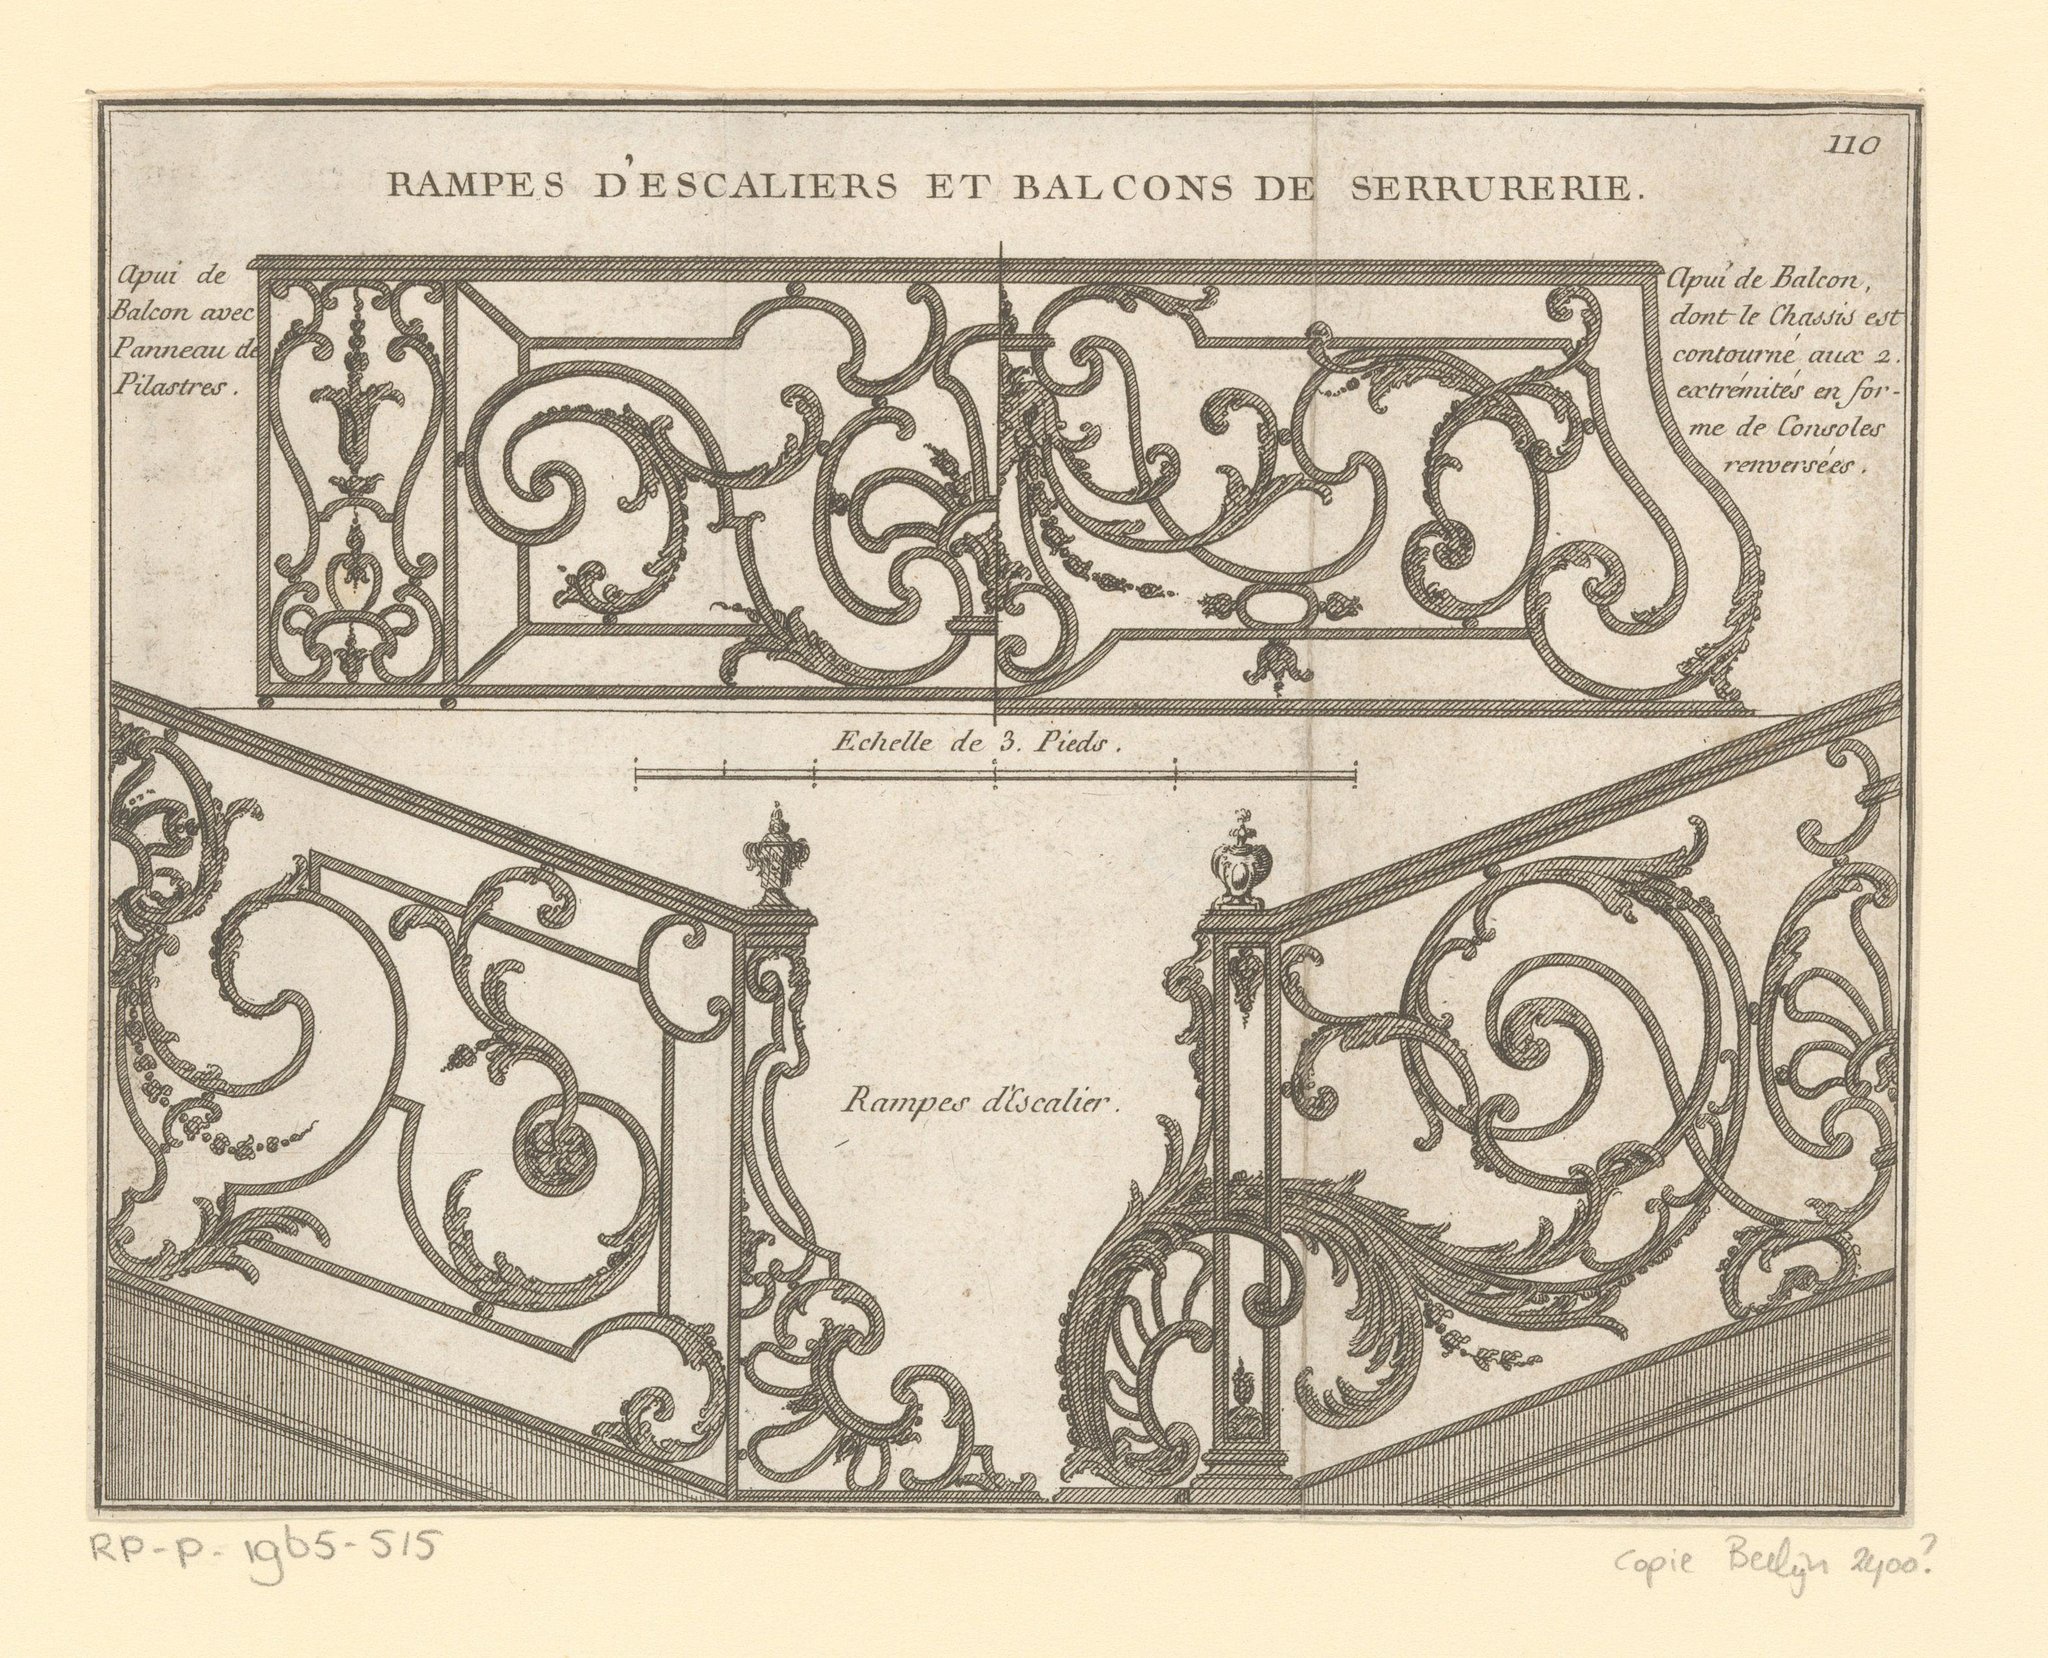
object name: ornament print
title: Rampes d'escaliers et balcons de serrurerie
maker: Anonymous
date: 1738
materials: paper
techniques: engraving, etching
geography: france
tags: balustrade, staircase, forging (industrial process)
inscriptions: collector's mark: Lugt 2228, collector's mark: Lugt 2760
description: Twee smeedijzeren balustrades en twee smeedijzeren traphekken met bladmotieven. Met Franse beschrijving. Prentnummer 110.